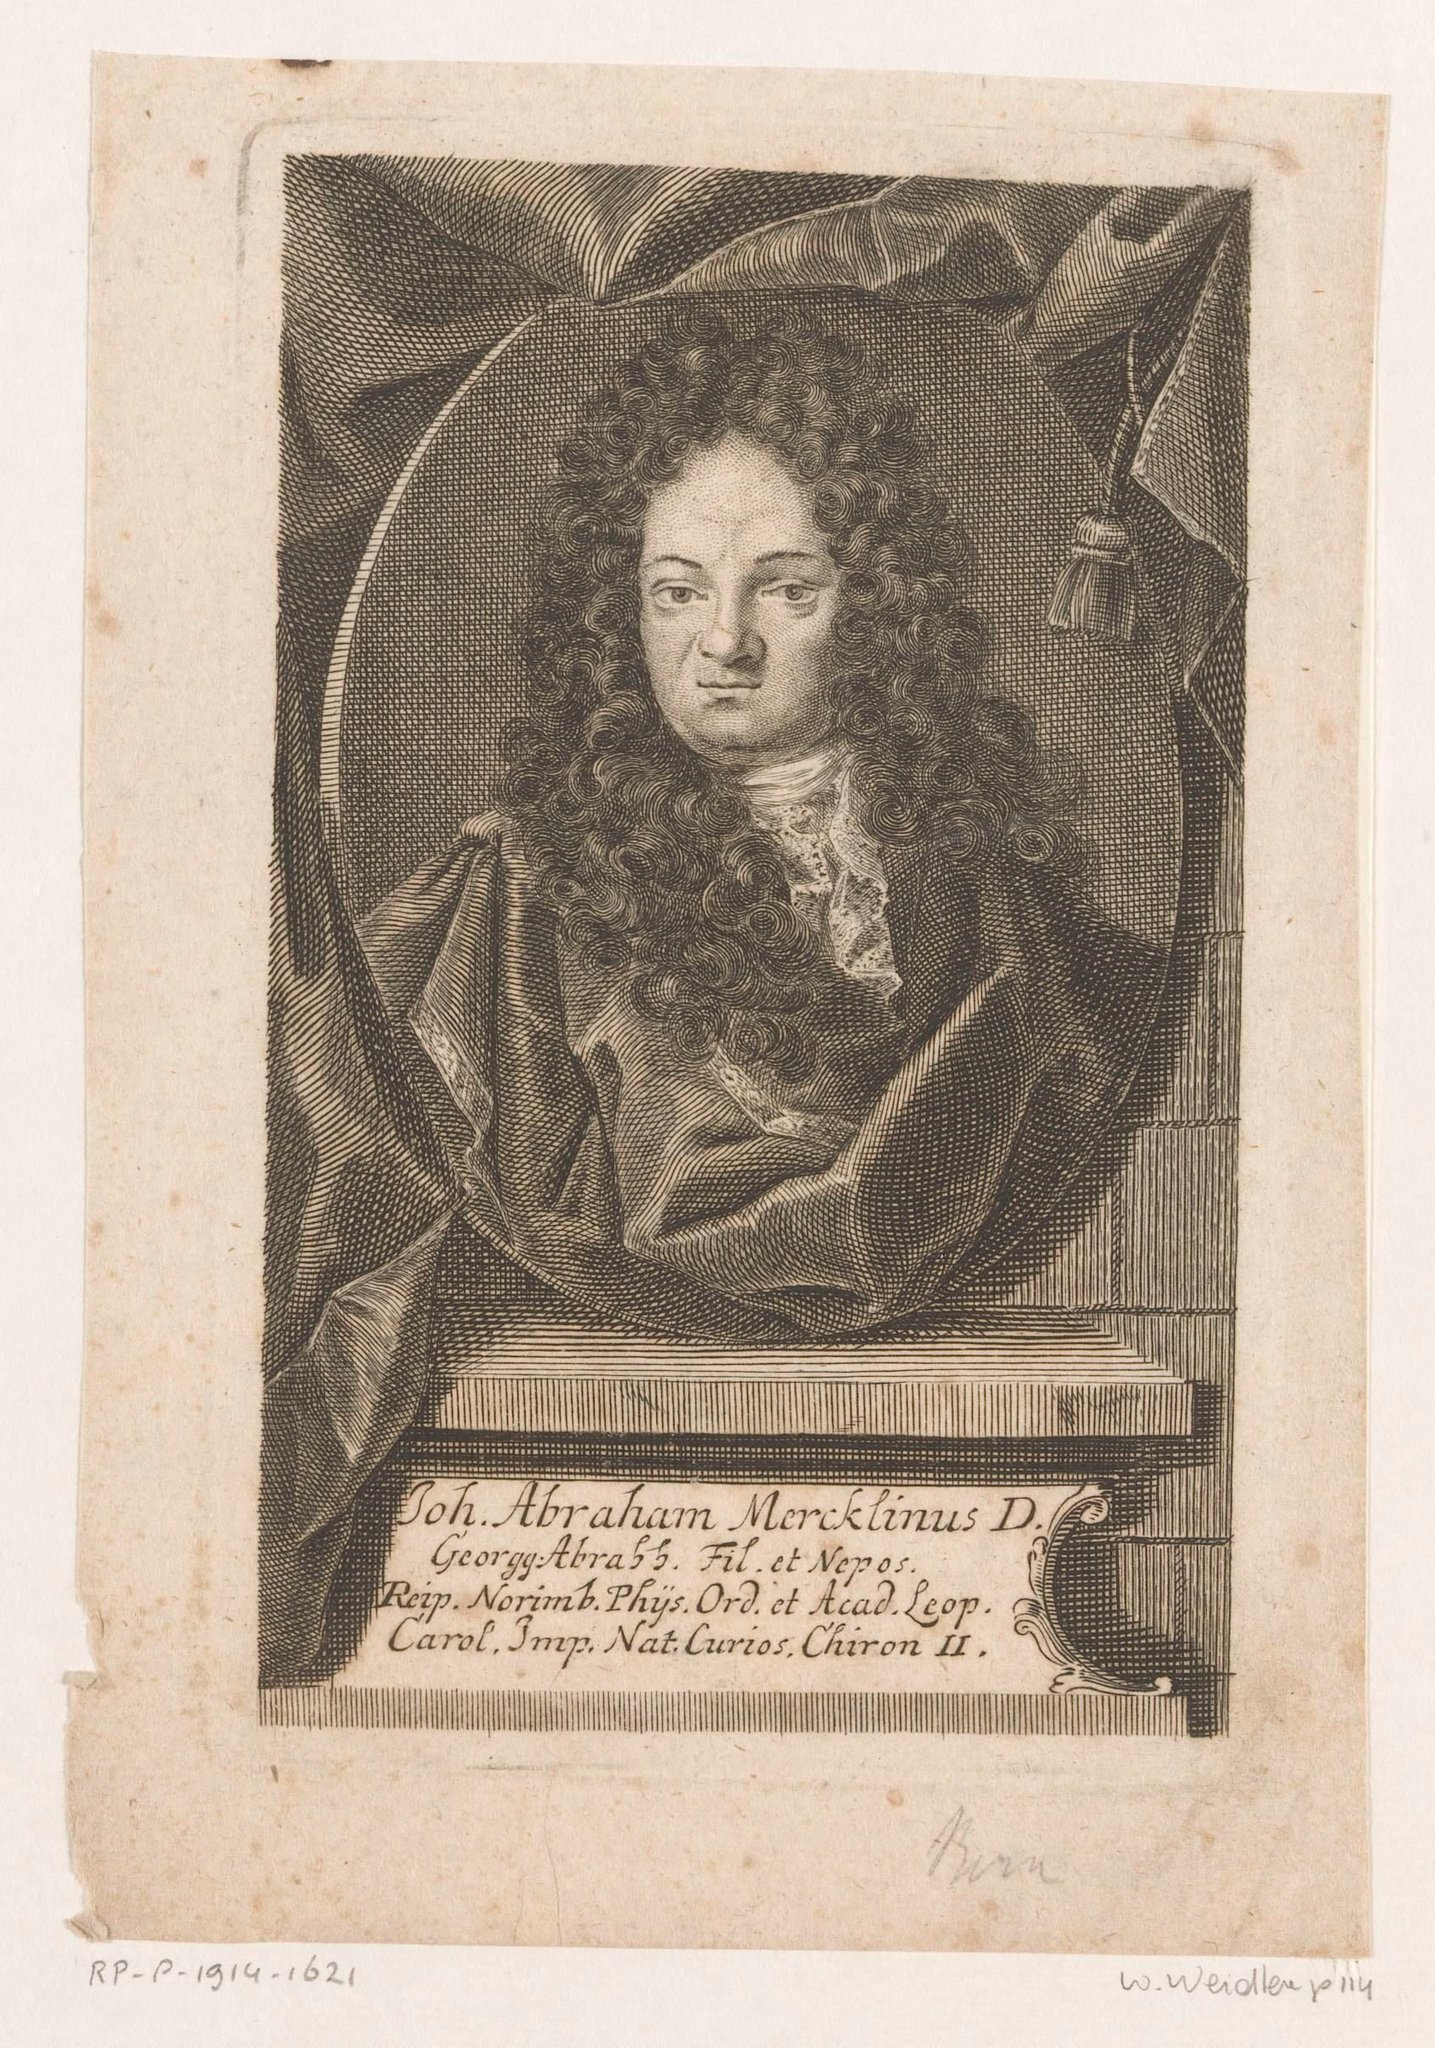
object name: print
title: Portret van Johann Abraham Mercklin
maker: martin bernigeroth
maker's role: print maker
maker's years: 1670-1733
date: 1715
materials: paper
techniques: engraving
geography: leipzig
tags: historical persons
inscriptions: collector's mark: Lugt 2228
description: Prent ook gebruikt in: Deutsche Acta Eruditorum (...). dl. 30. Leipzig: Johann Gottlieb Gleditsch, 1715.